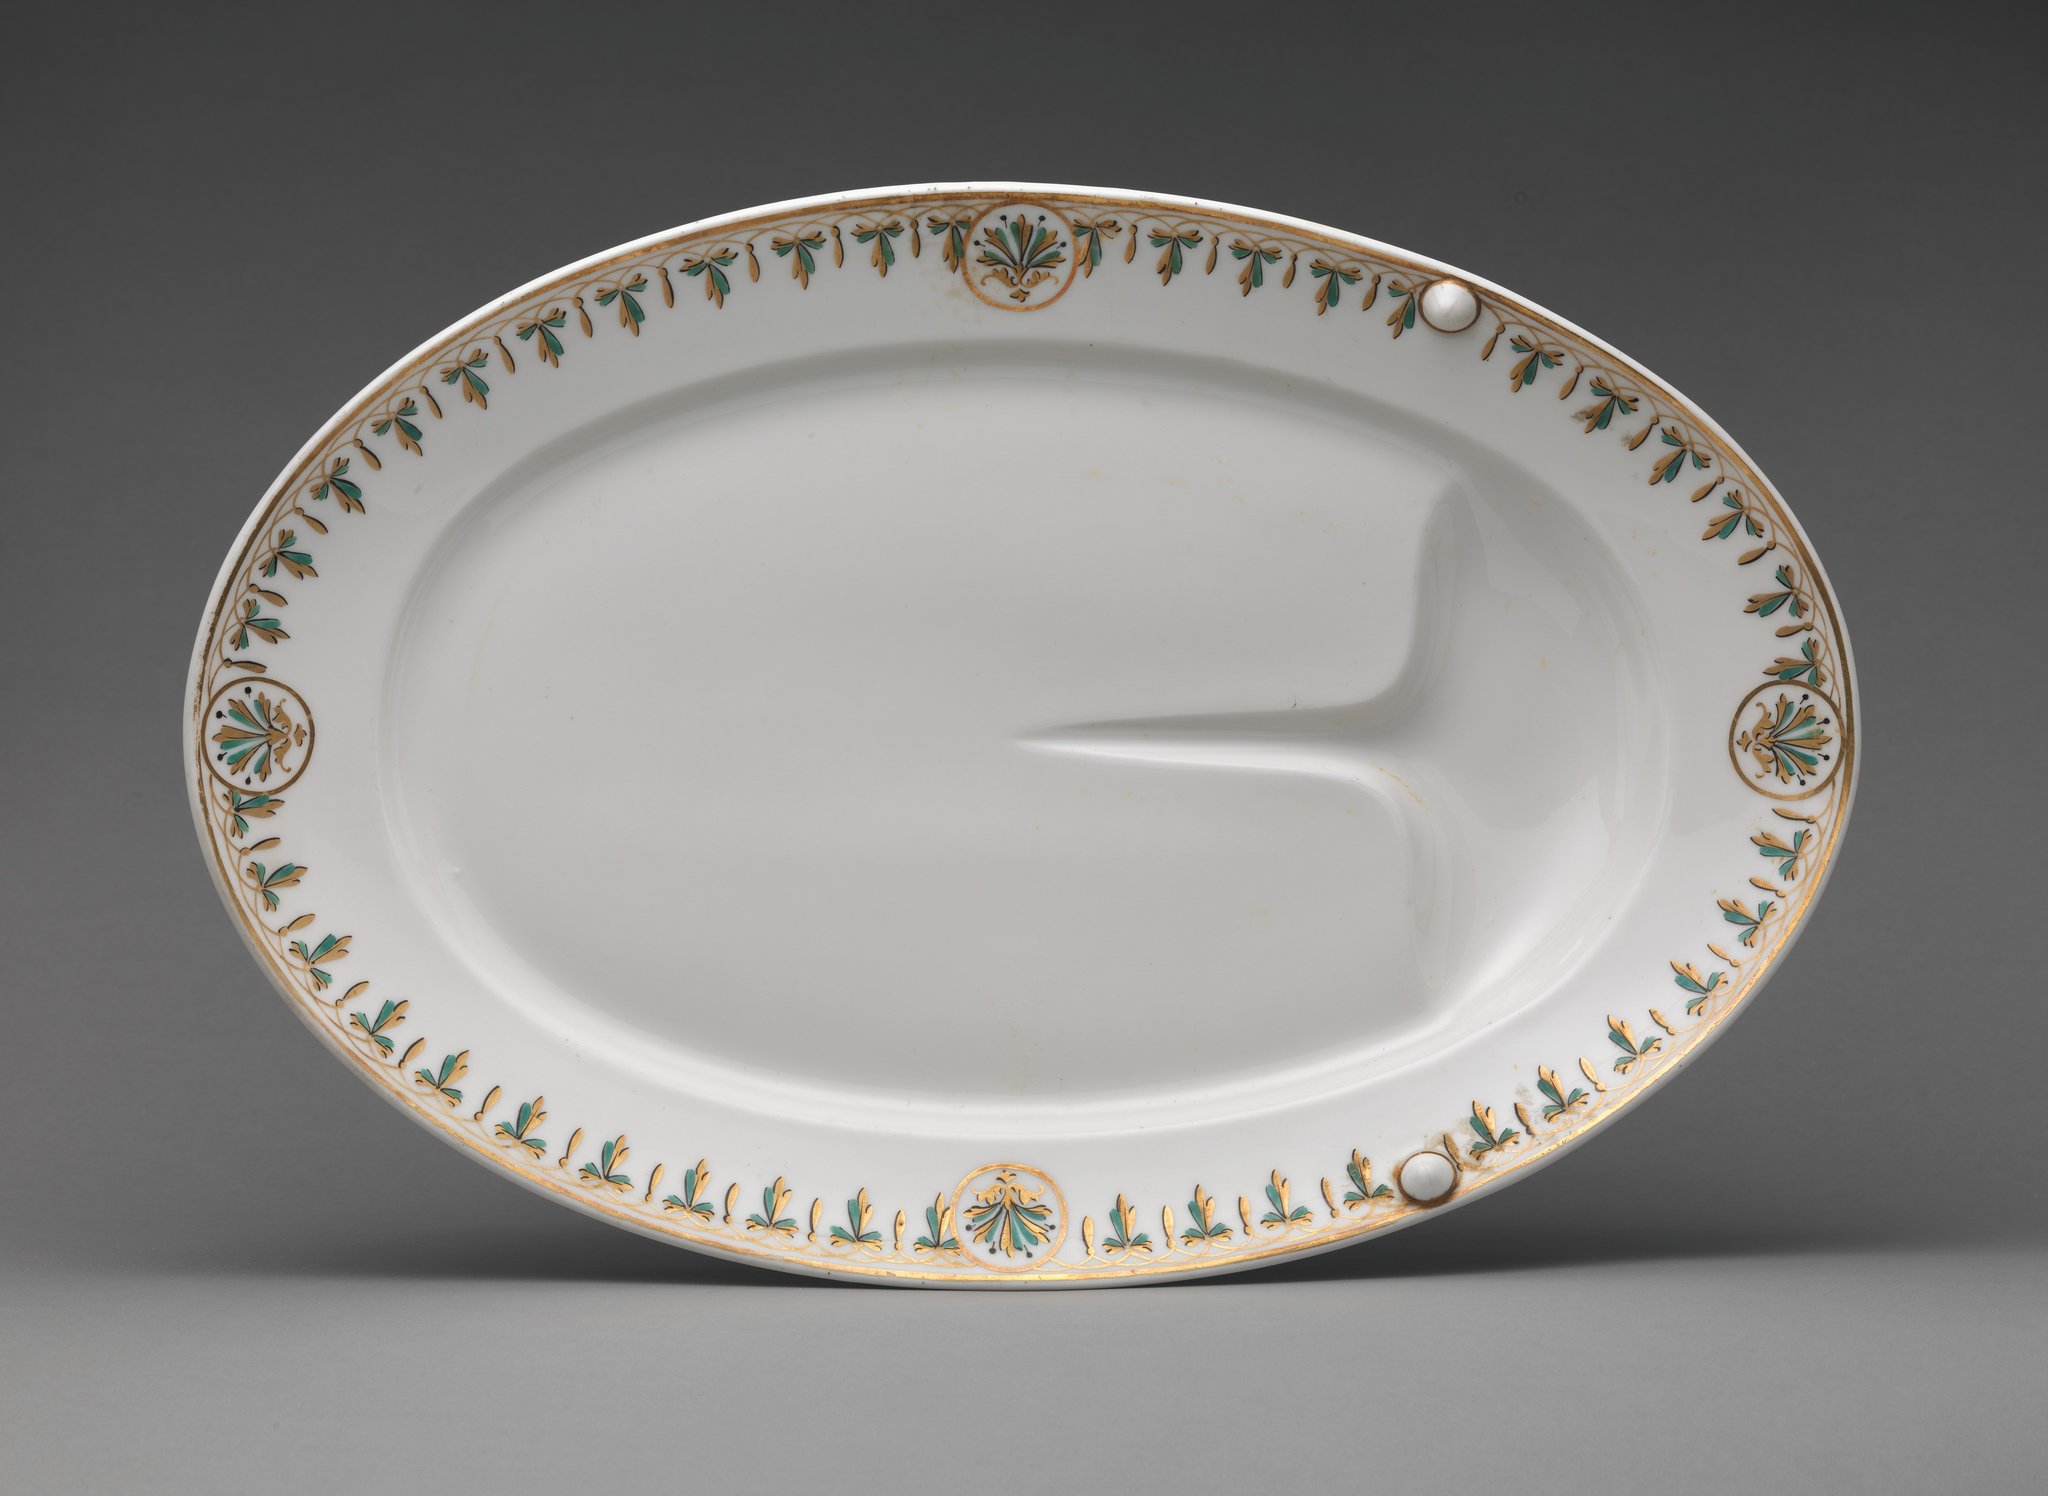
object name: roast platter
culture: american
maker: union porcelain works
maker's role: maker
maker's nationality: american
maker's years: 1863-1922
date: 1885-1886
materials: porcelain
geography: united states